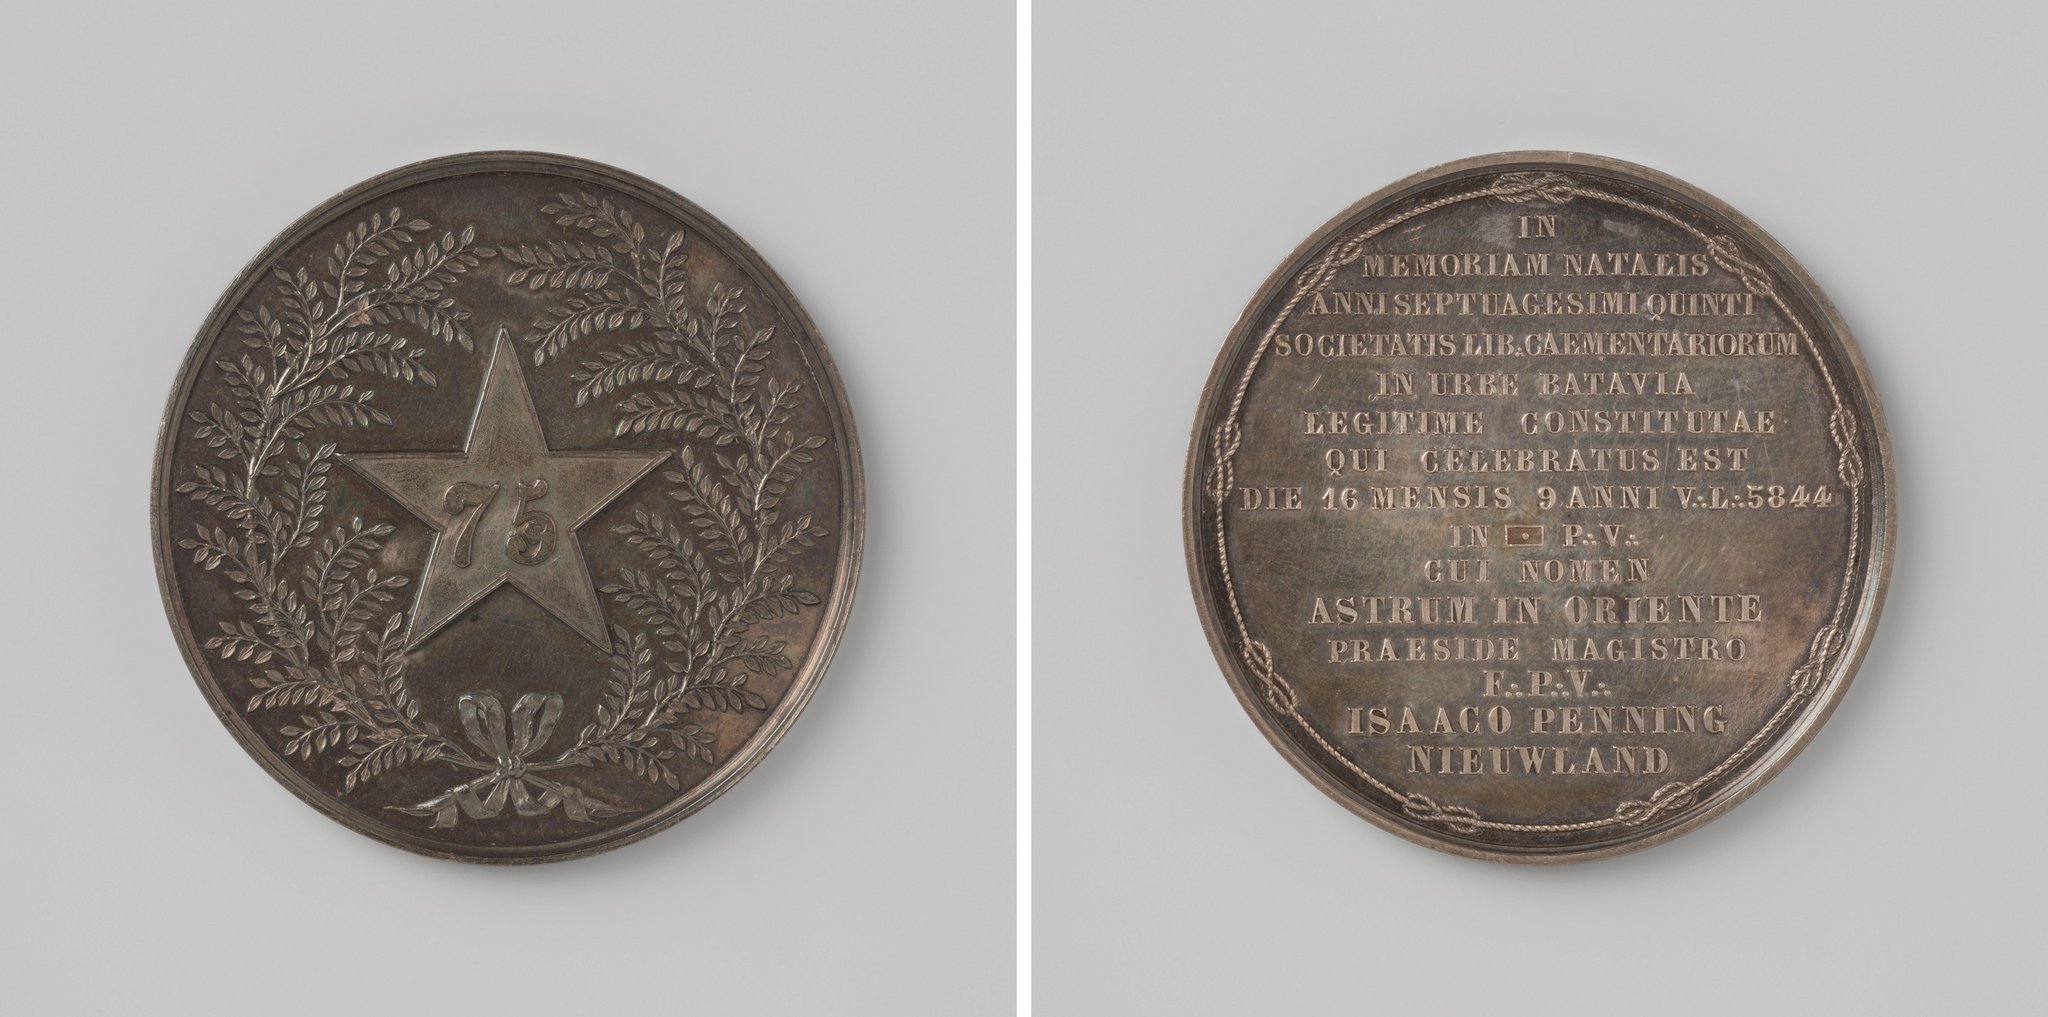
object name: history medal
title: Vijfenzeventigjarig bestaan van de loge der vrijmetselaars Ster in het Oosten te Batavia 1844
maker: wiener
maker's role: medailleur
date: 1844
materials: silver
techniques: striking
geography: brussels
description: Zilveren penning, op de voorzijde een vijfpuntige ster, waarop het cijfer 75, tussen samengestrikte acaciatakken, op de keerzijde vijftien regels tekst binnen een koord waarin negen knopen.